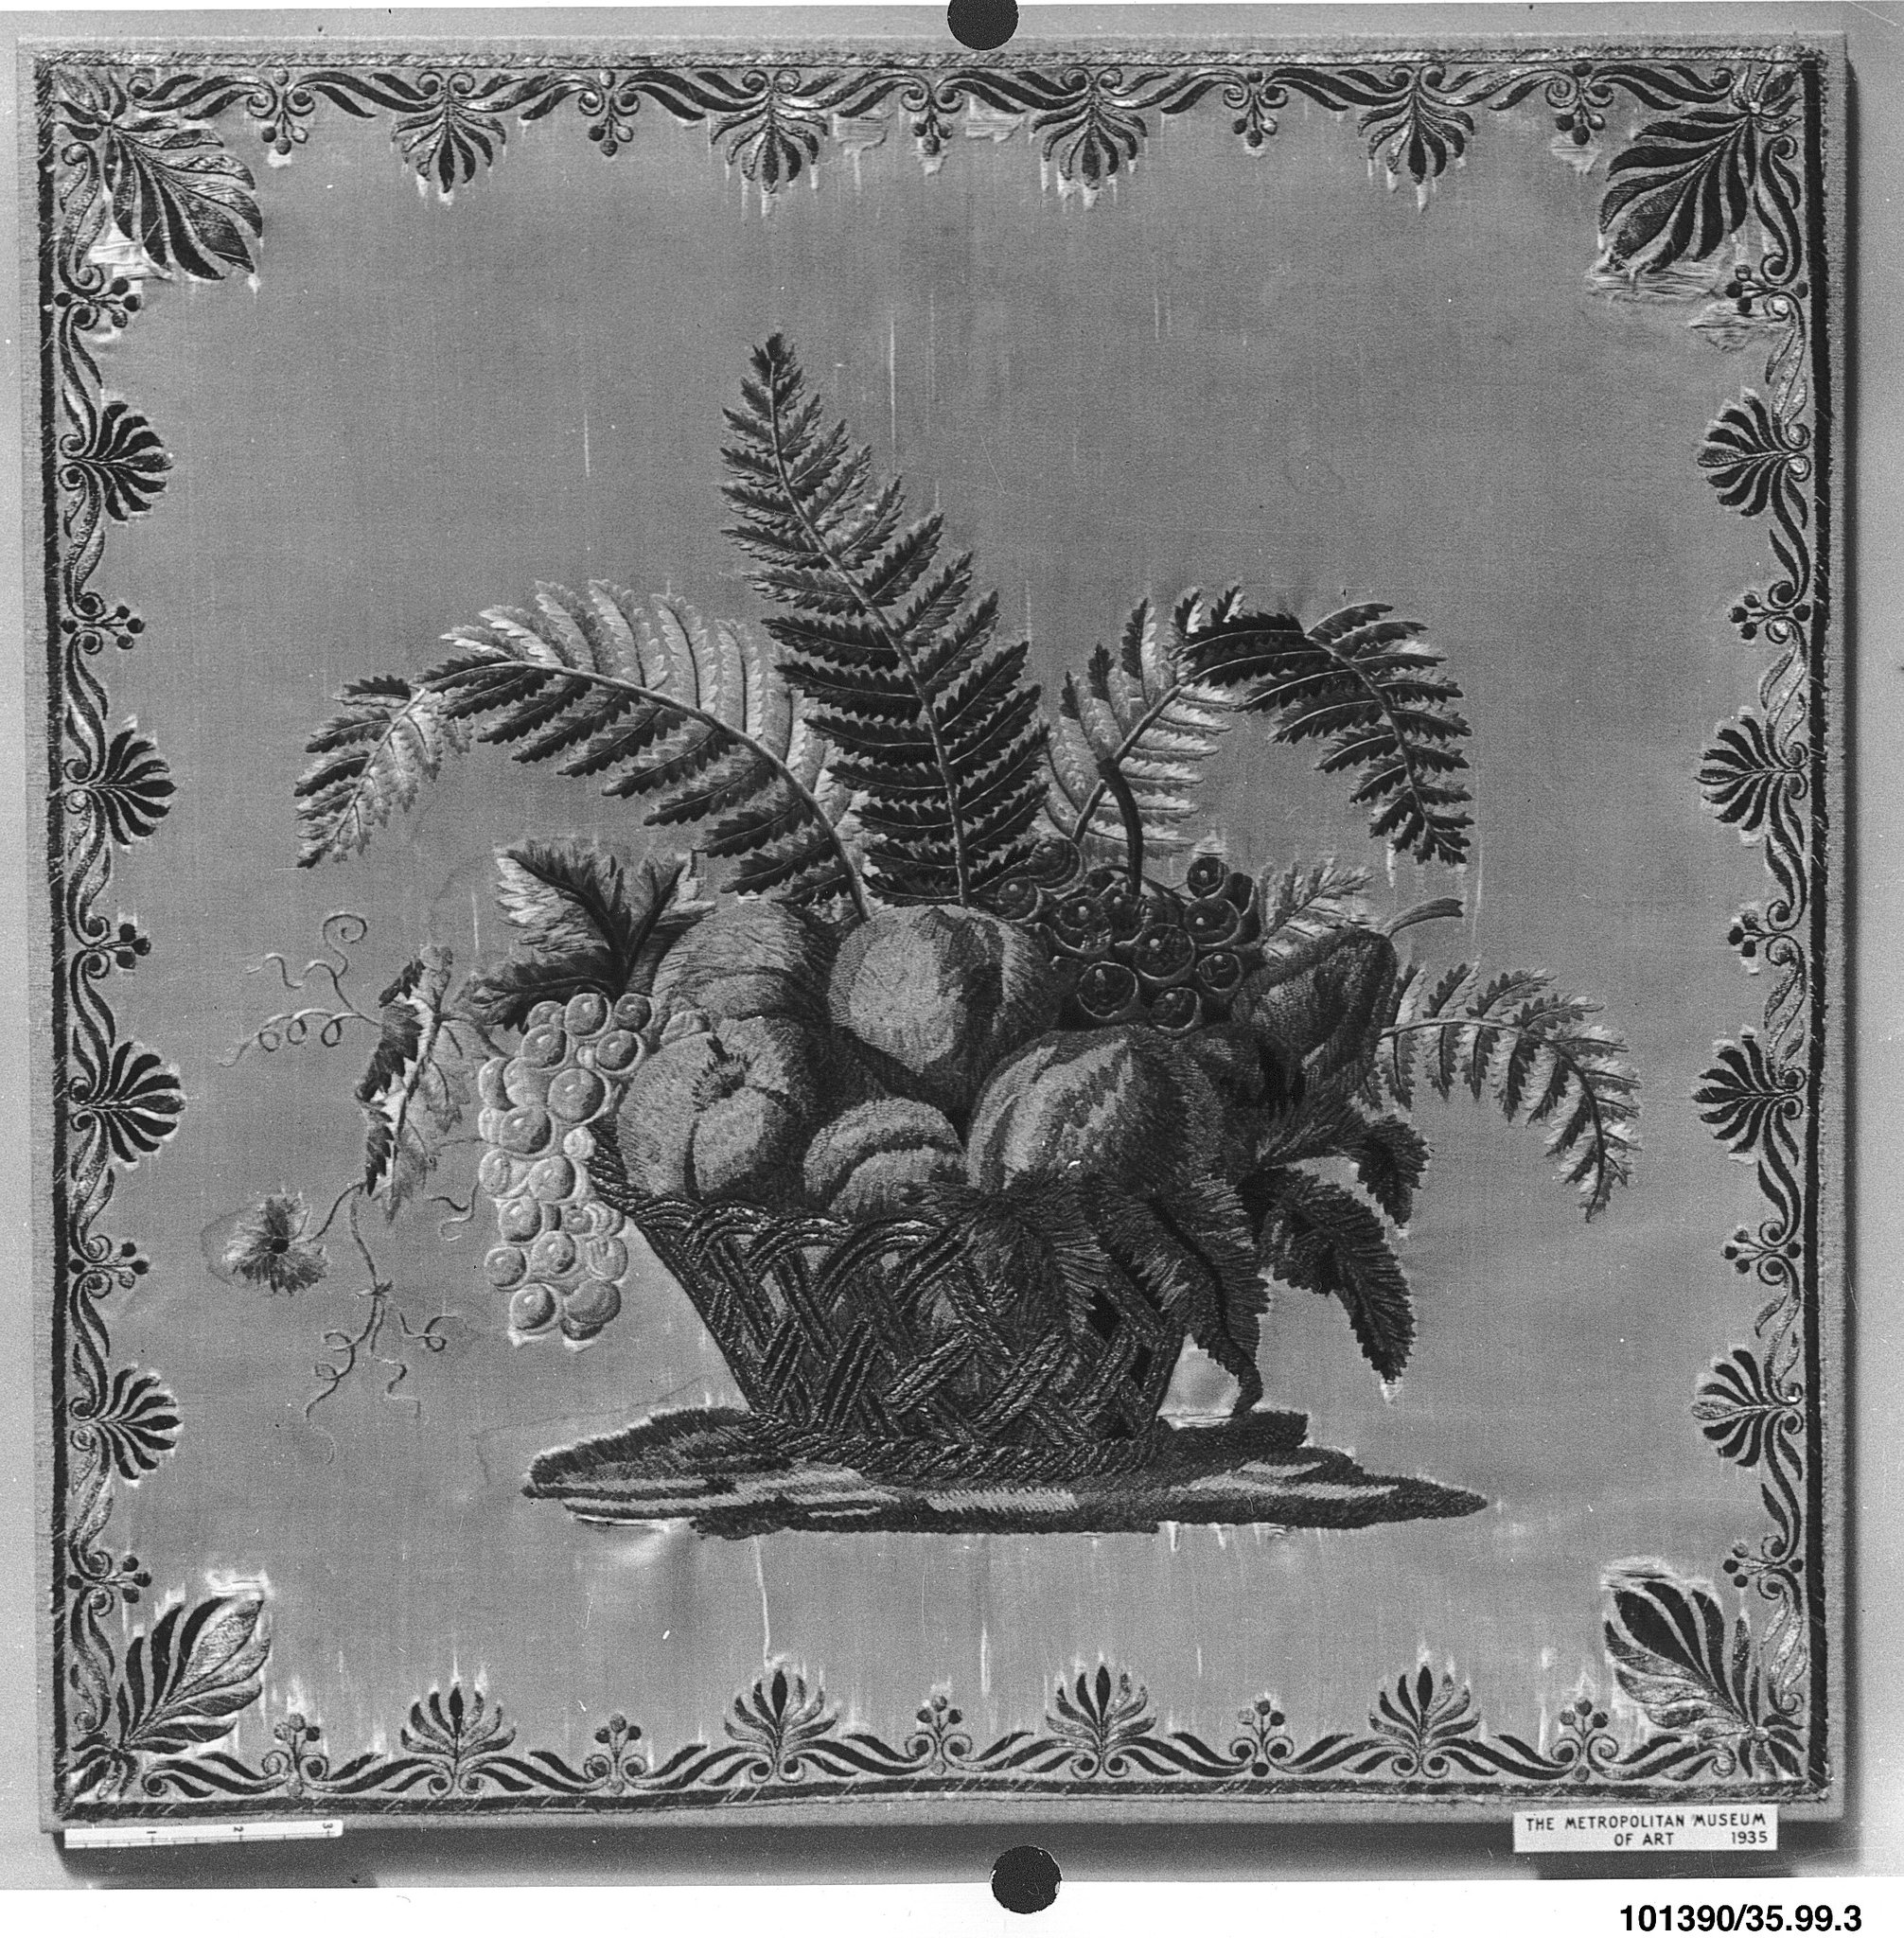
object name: cushion cover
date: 1795-1805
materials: metal thread, silk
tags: grapes